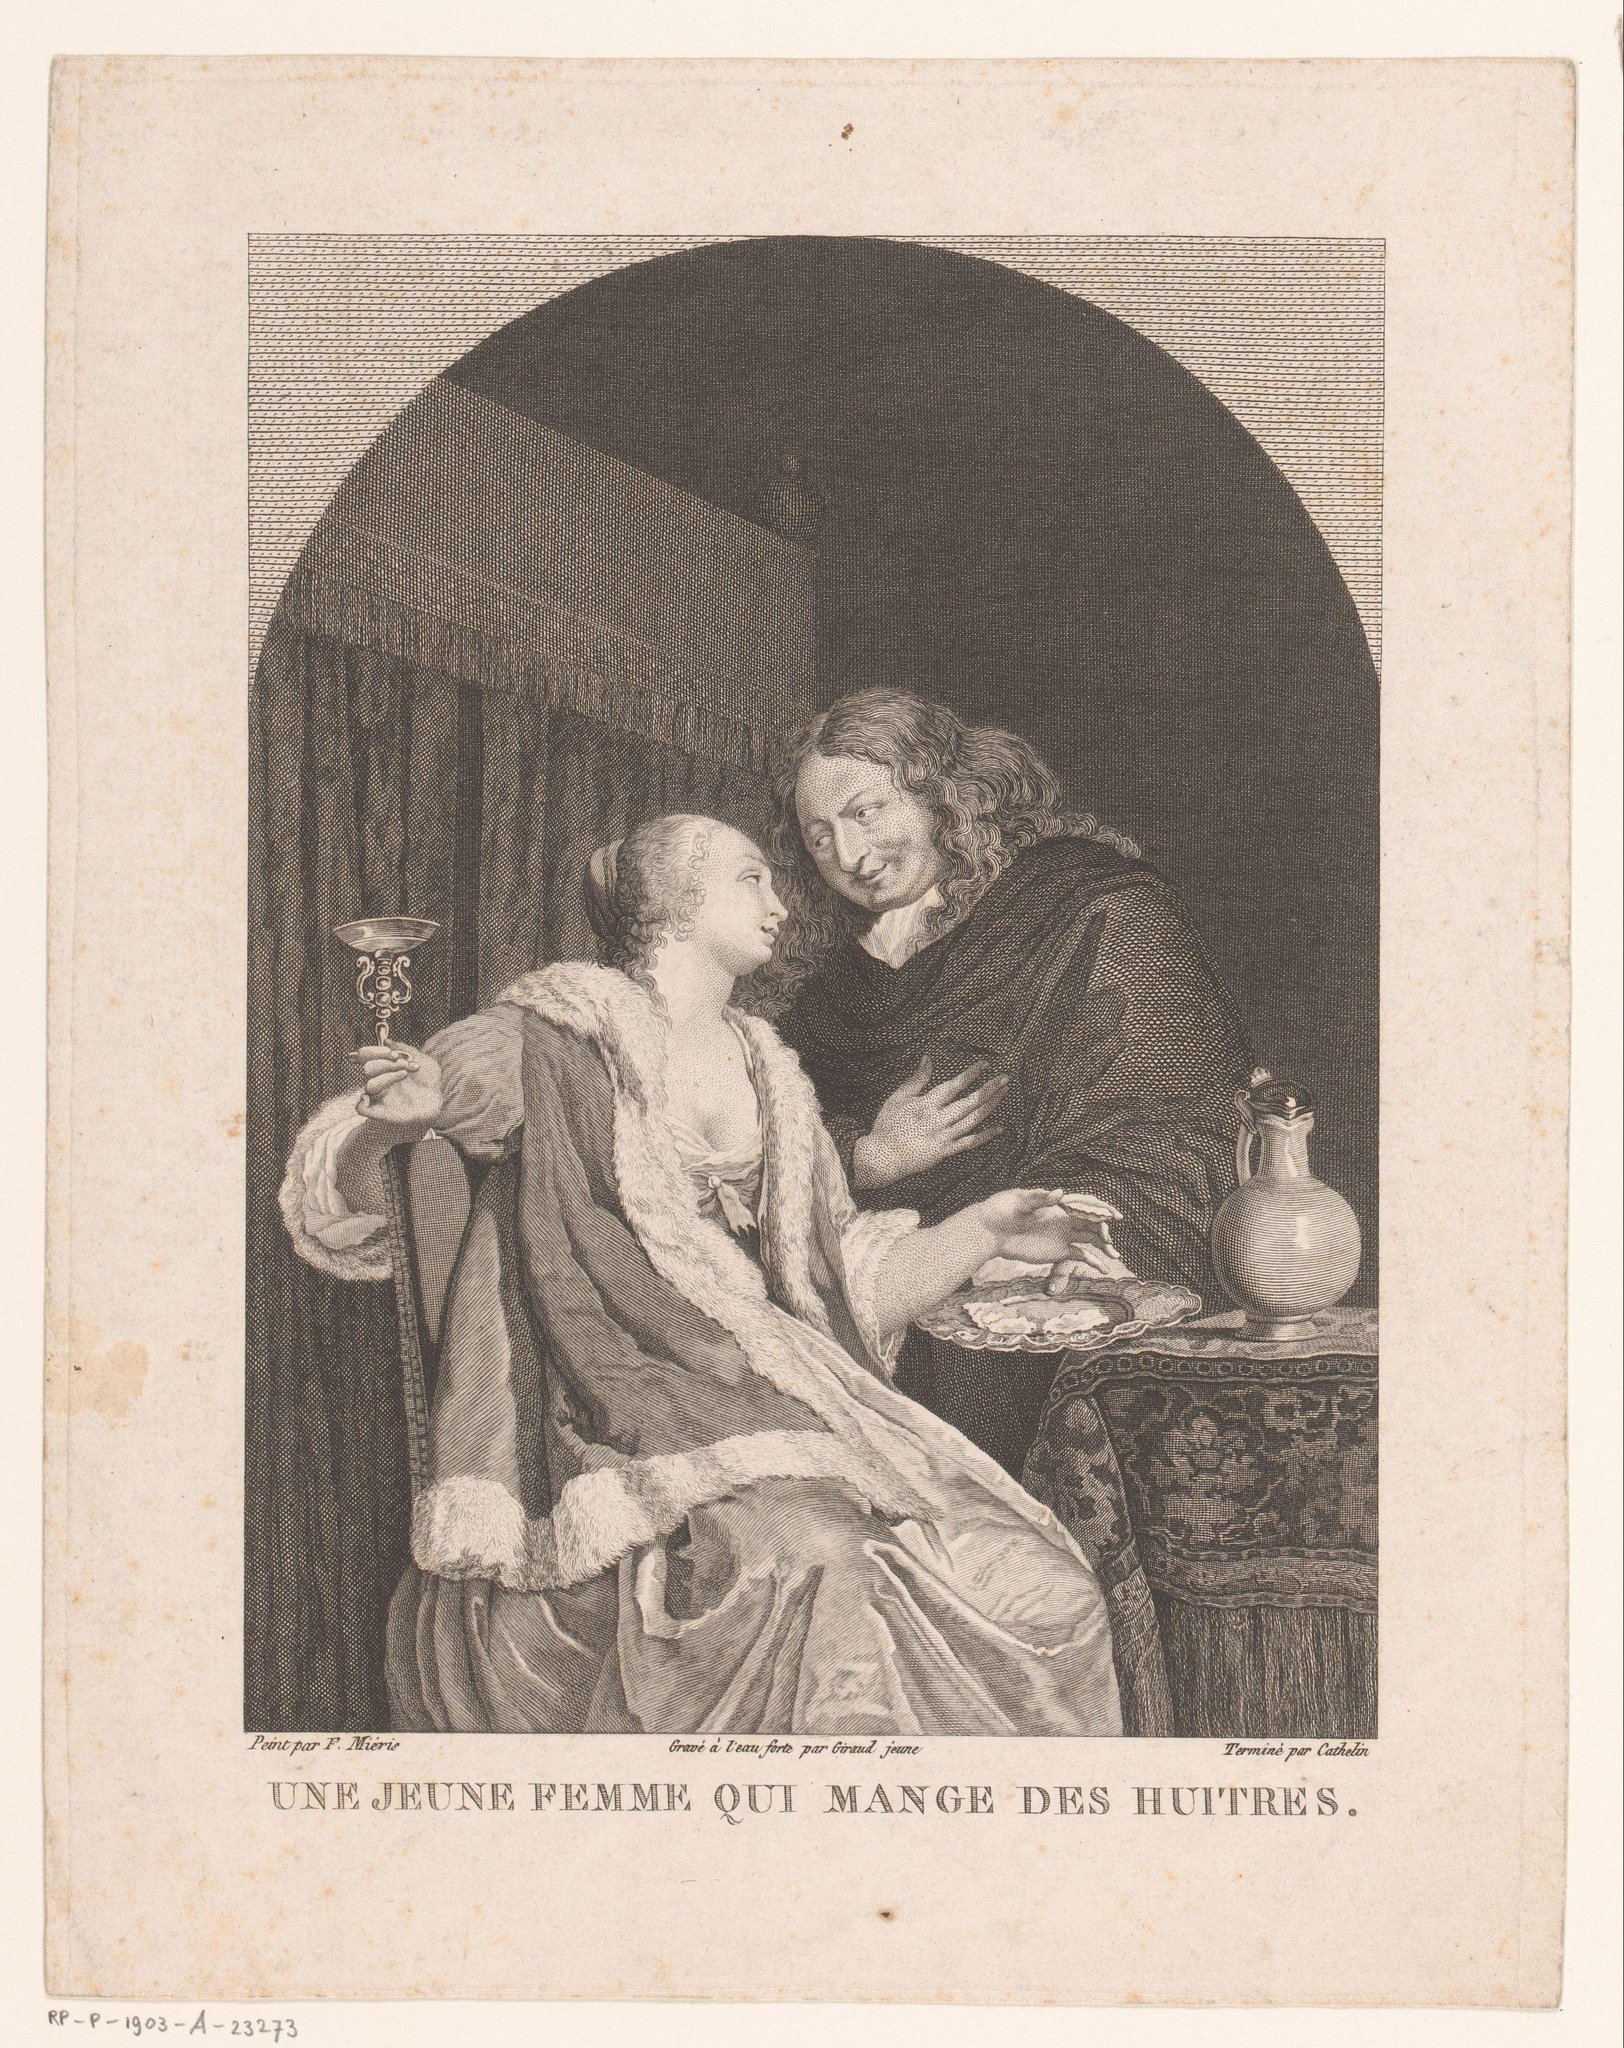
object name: print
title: Galerie du Palais Royal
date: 1786-1808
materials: paper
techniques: engraving, etching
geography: paris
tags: molluscs: oyster, evening meal, dinner, supper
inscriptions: collector's mark: Lugt 2228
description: Onderdeel van een serie van 354 prenten naar schilderijen uit de collectie van de Hertog van Orléans, getiteld: La Galerie du Palais Royal, uitgebracht tussen 1786 en 1808. De serie werd uitgegeven door Jacques Couché die het project samen met Jacques Bouillard leidde.